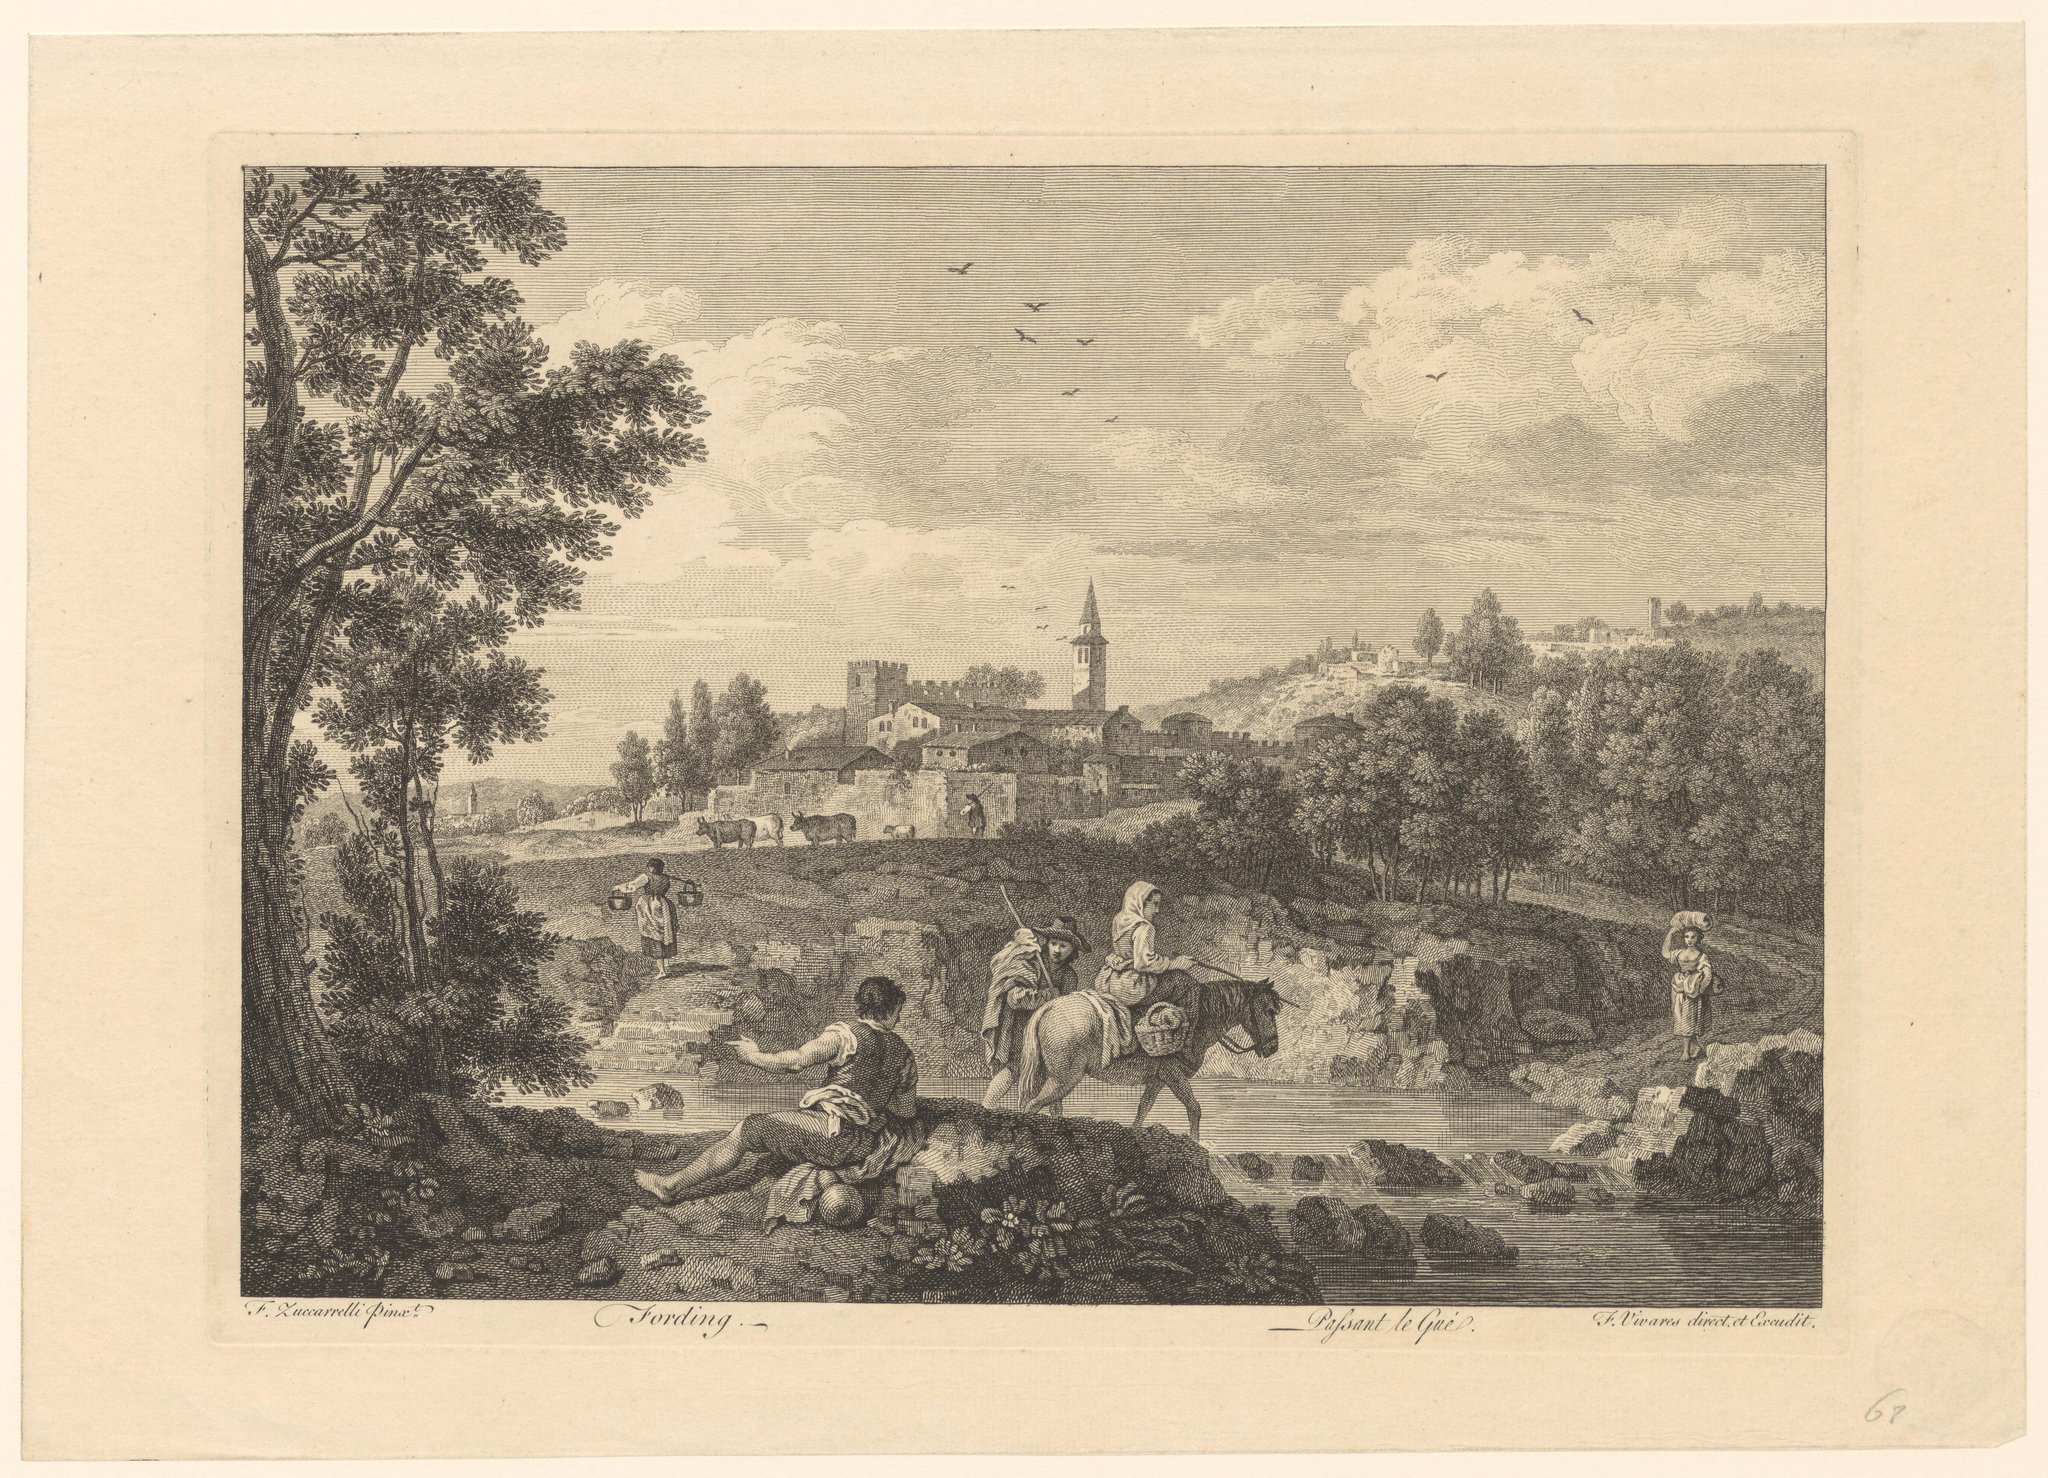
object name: print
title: Fording / Passant le Gué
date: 1719-1780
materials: paper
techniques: etching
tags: ford, 'en route', traveller under way, prospect of village, silhouette of village (+ city(-scape) with figures, staffage)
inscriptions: collector's mark: Lugt 240